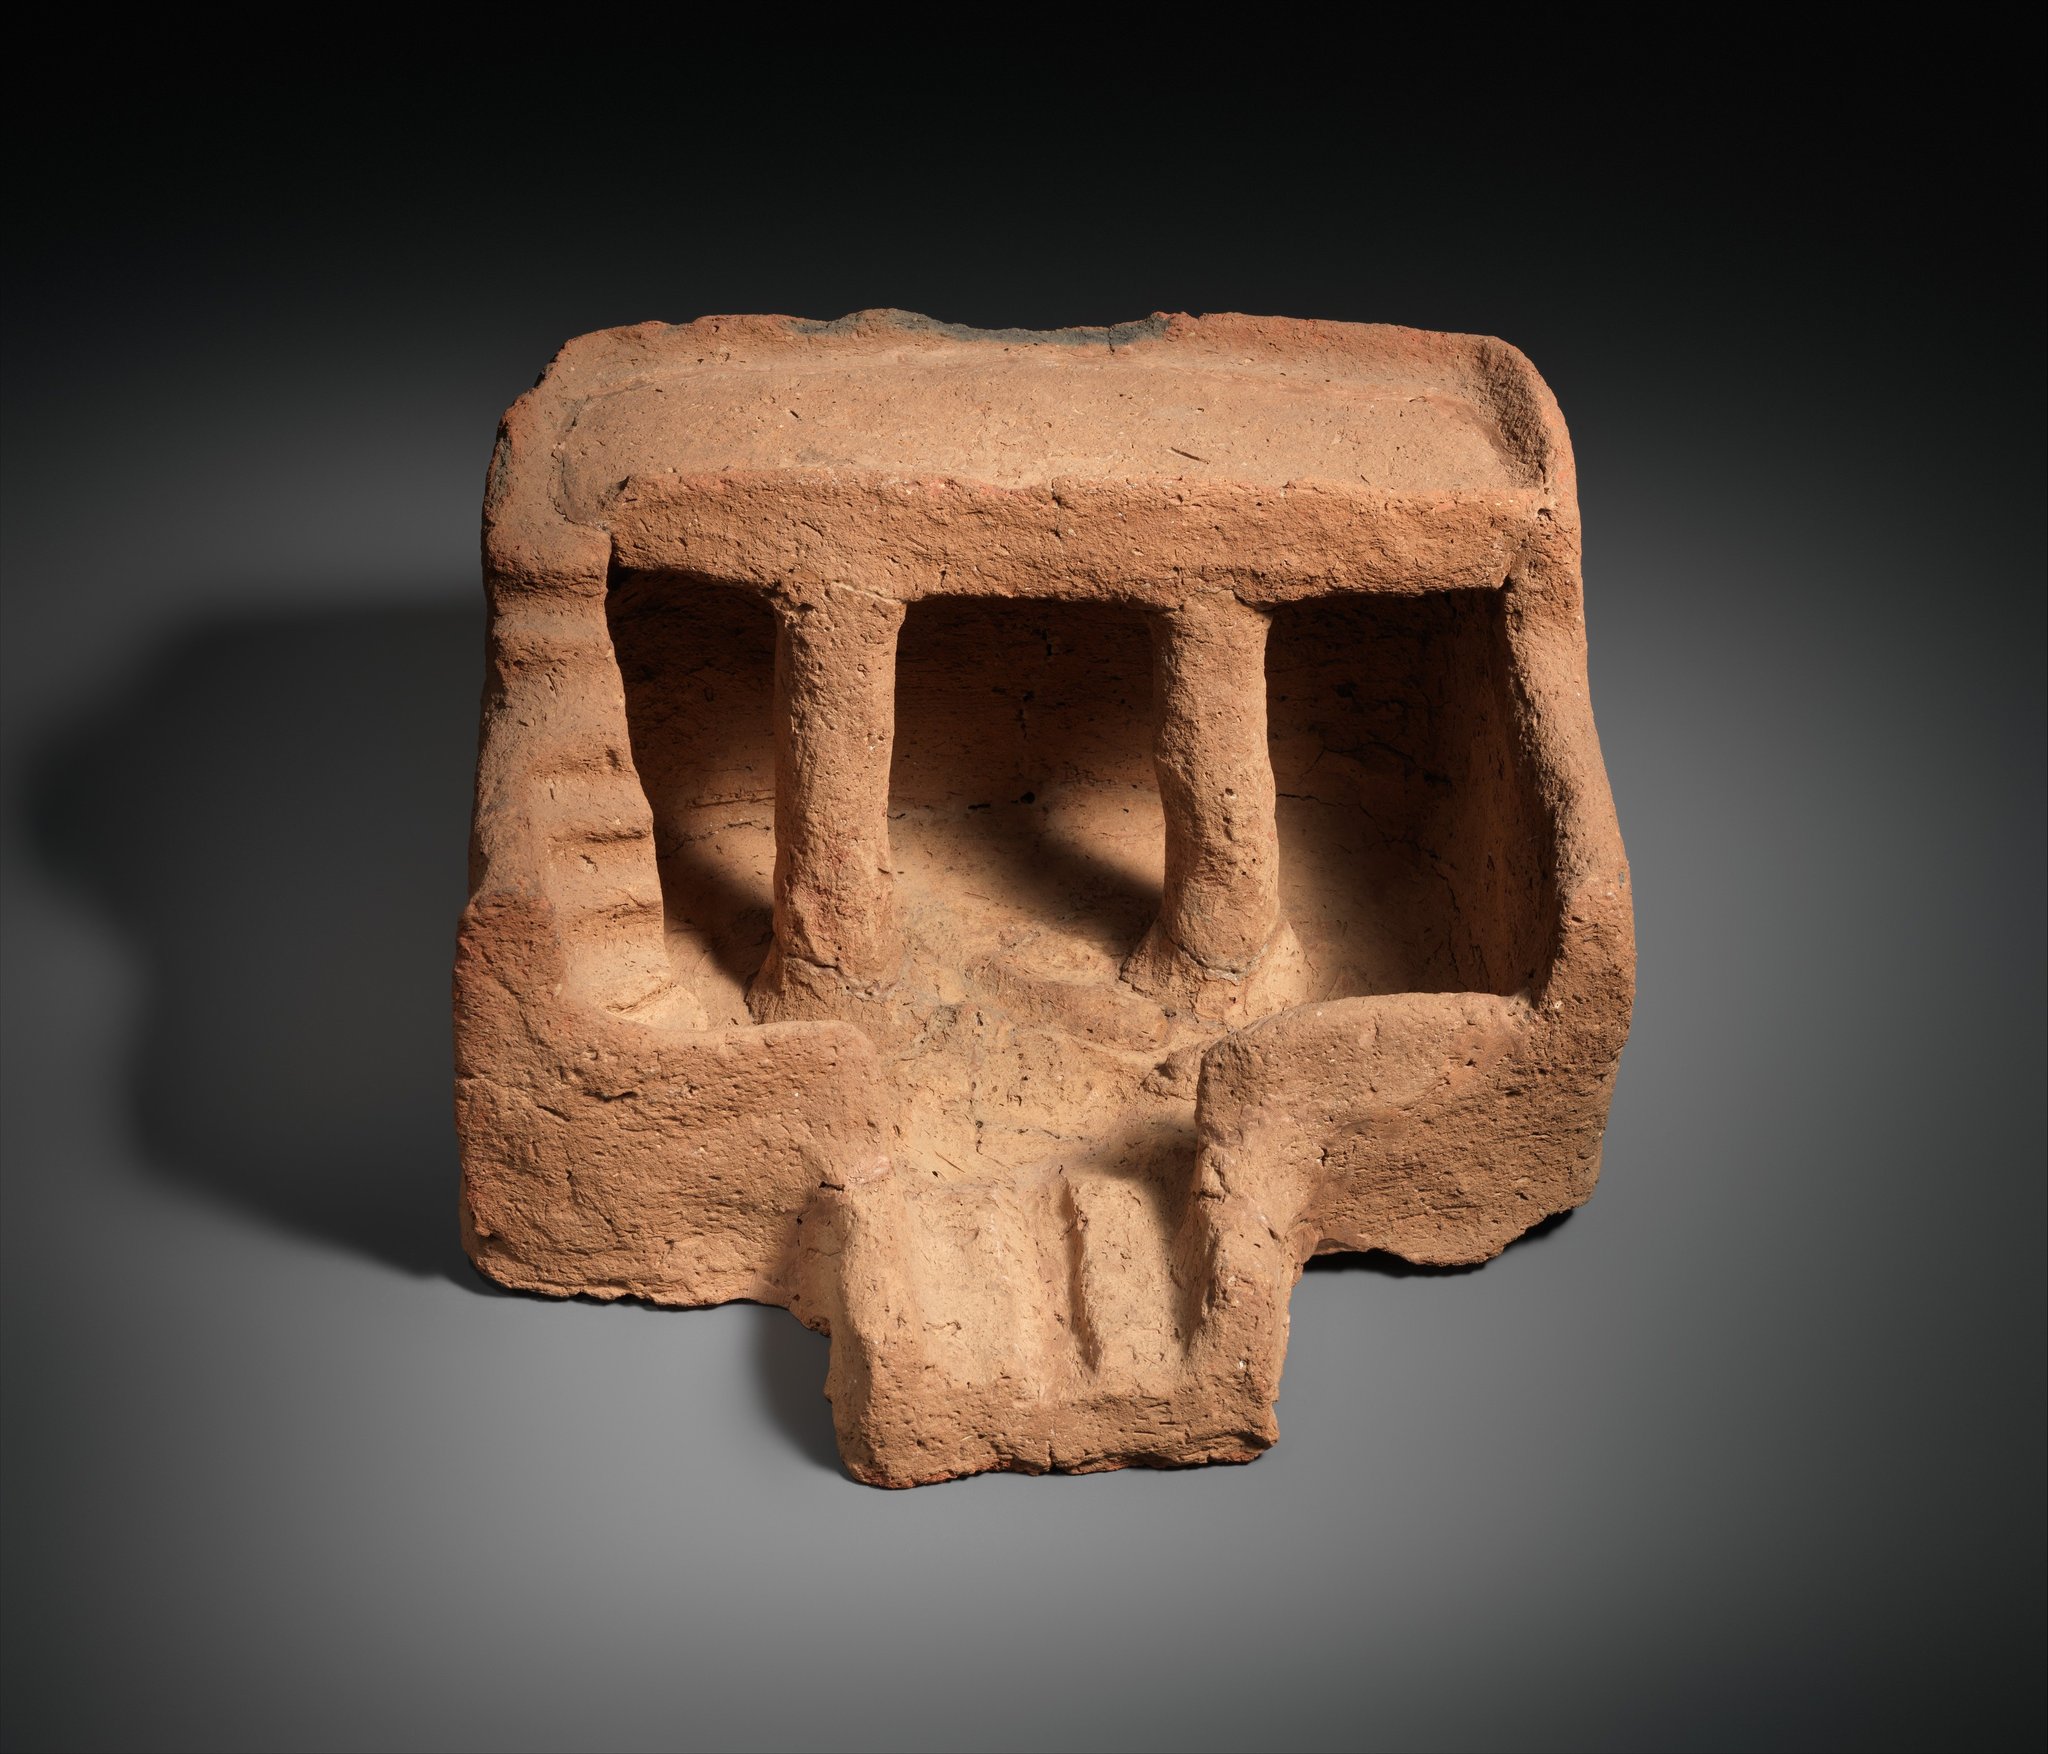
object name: model, house, soul house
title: Model of a house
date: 1750-1700 BCE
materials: pottery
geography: egypt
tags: houses